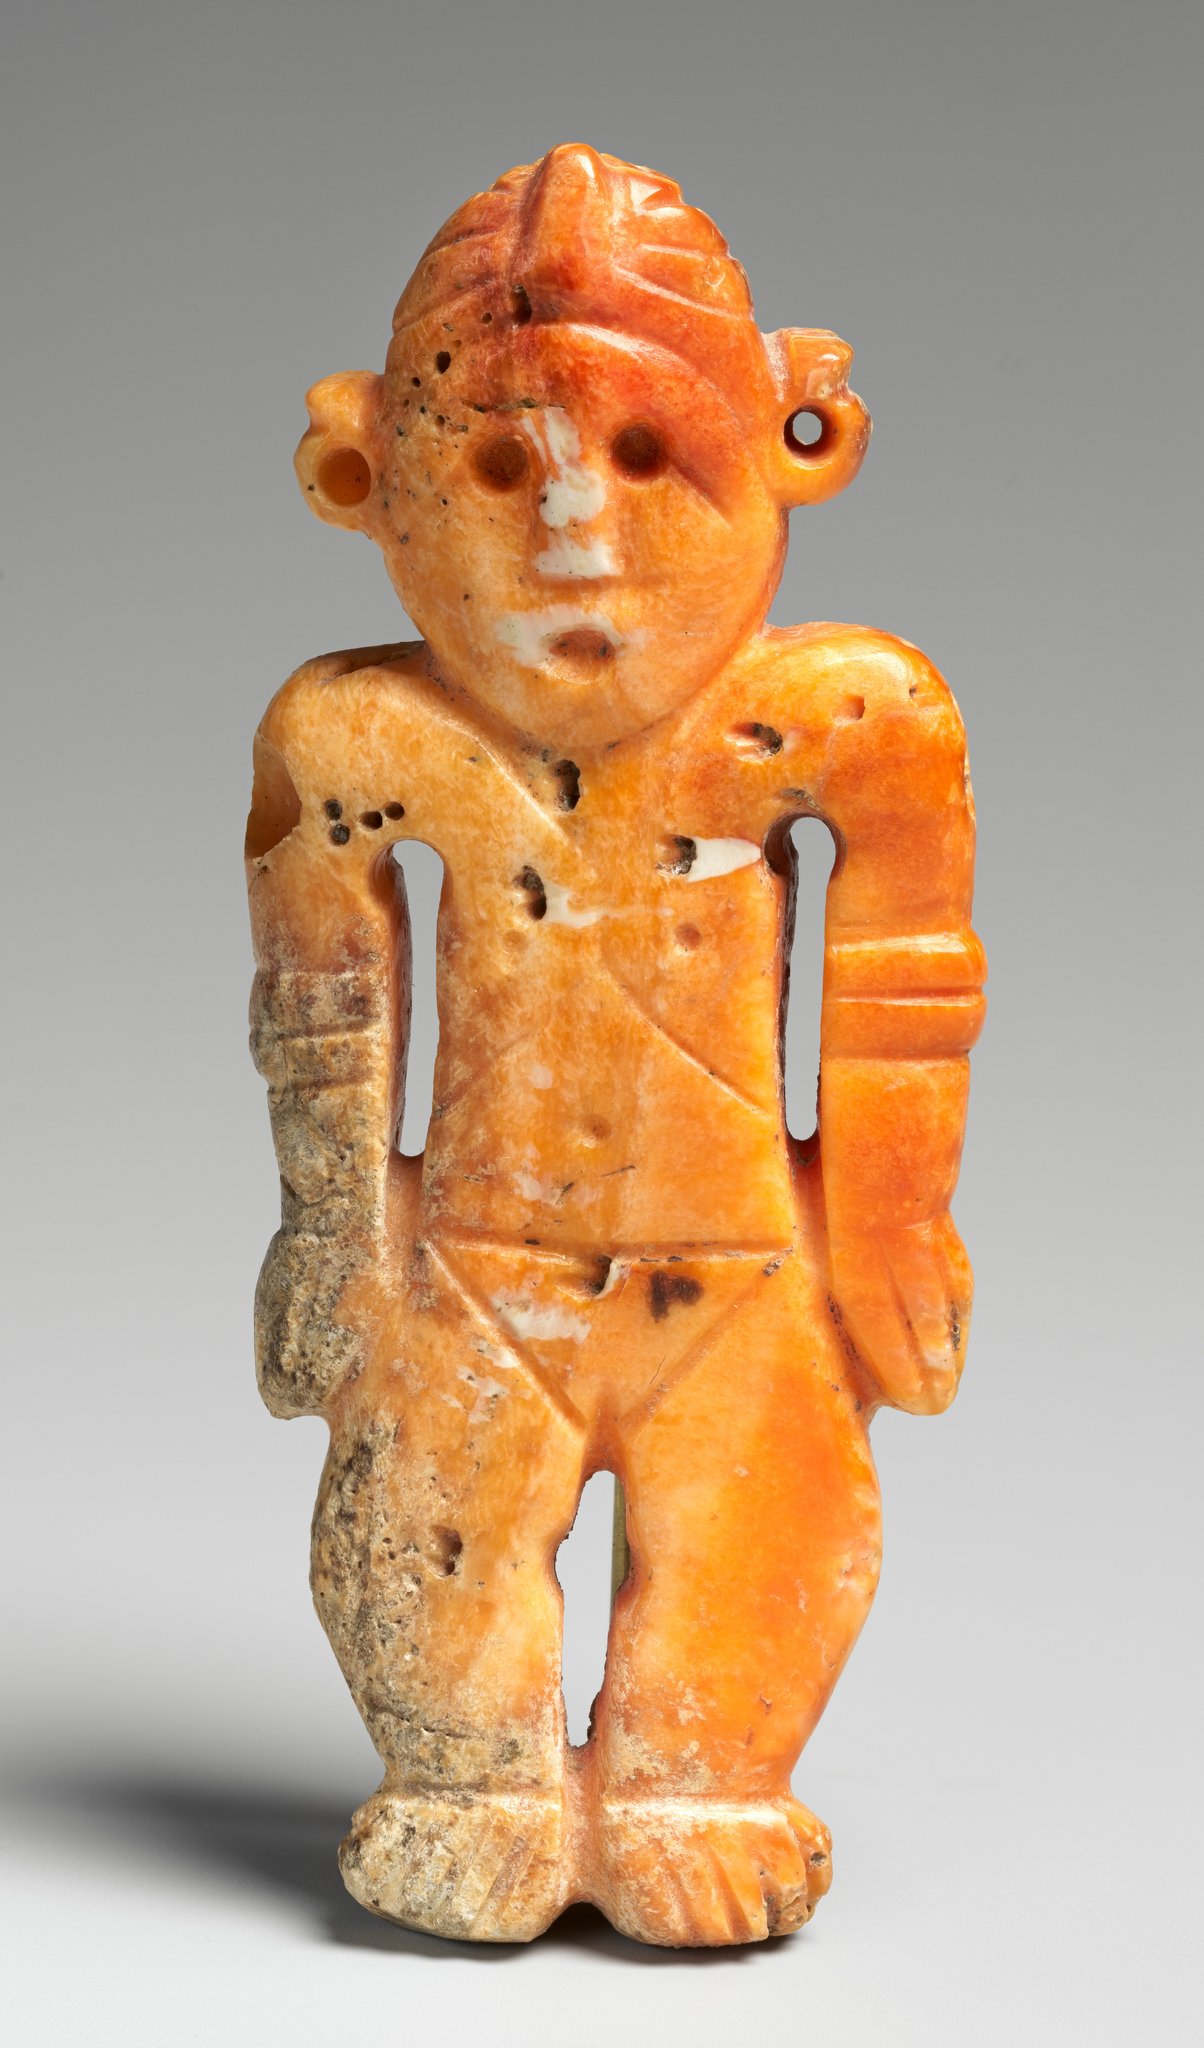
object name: pendant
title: Pendant Figure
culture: colima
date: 200 BCE-300 CE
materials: shell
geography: mexico